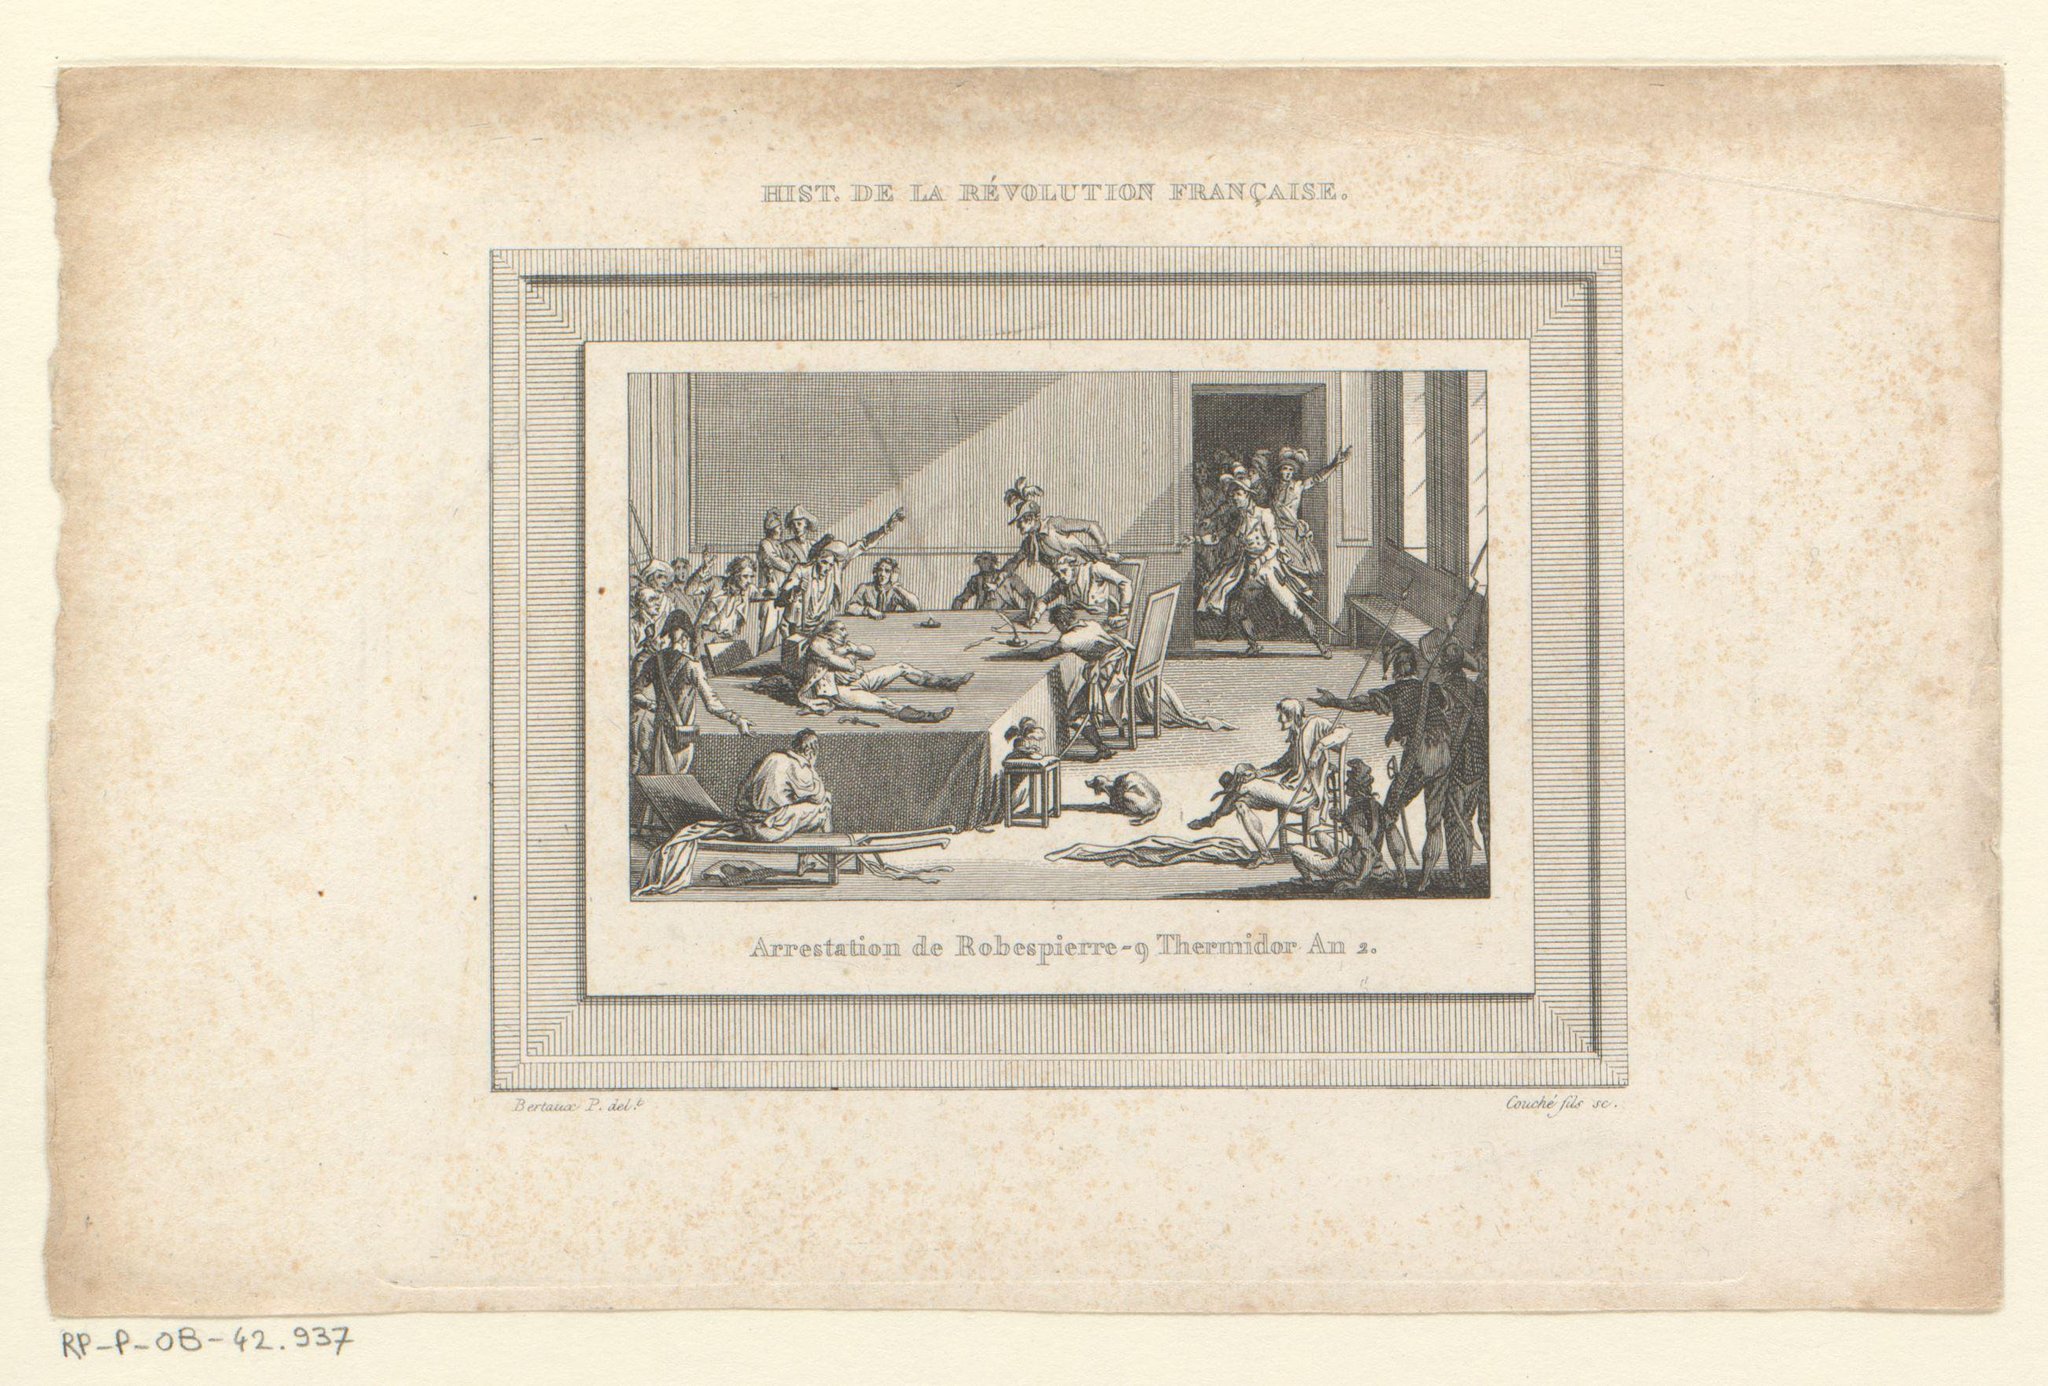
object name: print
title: Arrestatie van Robespierre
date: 1792-1849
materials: paper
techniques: etching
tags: paris, historical persons, arrest (of criminal)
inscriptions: collector's mark: Lugt 2228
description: Maakt deel uit van een serie getiteld 'Histoire de la Révolution Française' met belangrijke gebeurtenissen uit de Franse Revolutie.